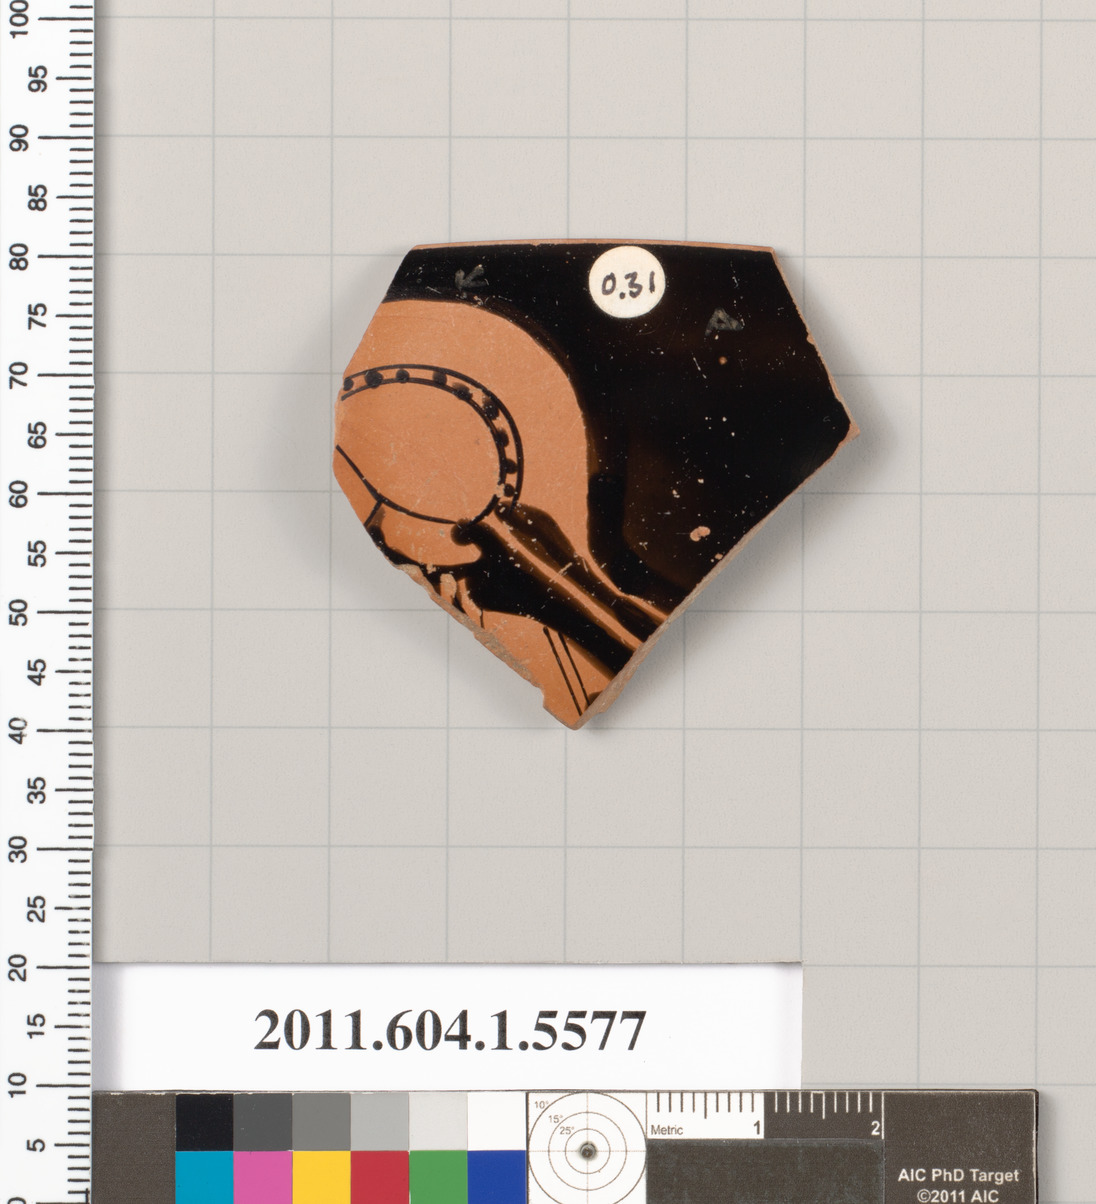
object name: kylix fragment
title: Terracotta rim fragment of a kylix (drinking cup)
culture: greek, attic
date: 500-490 BCE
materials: terracotta